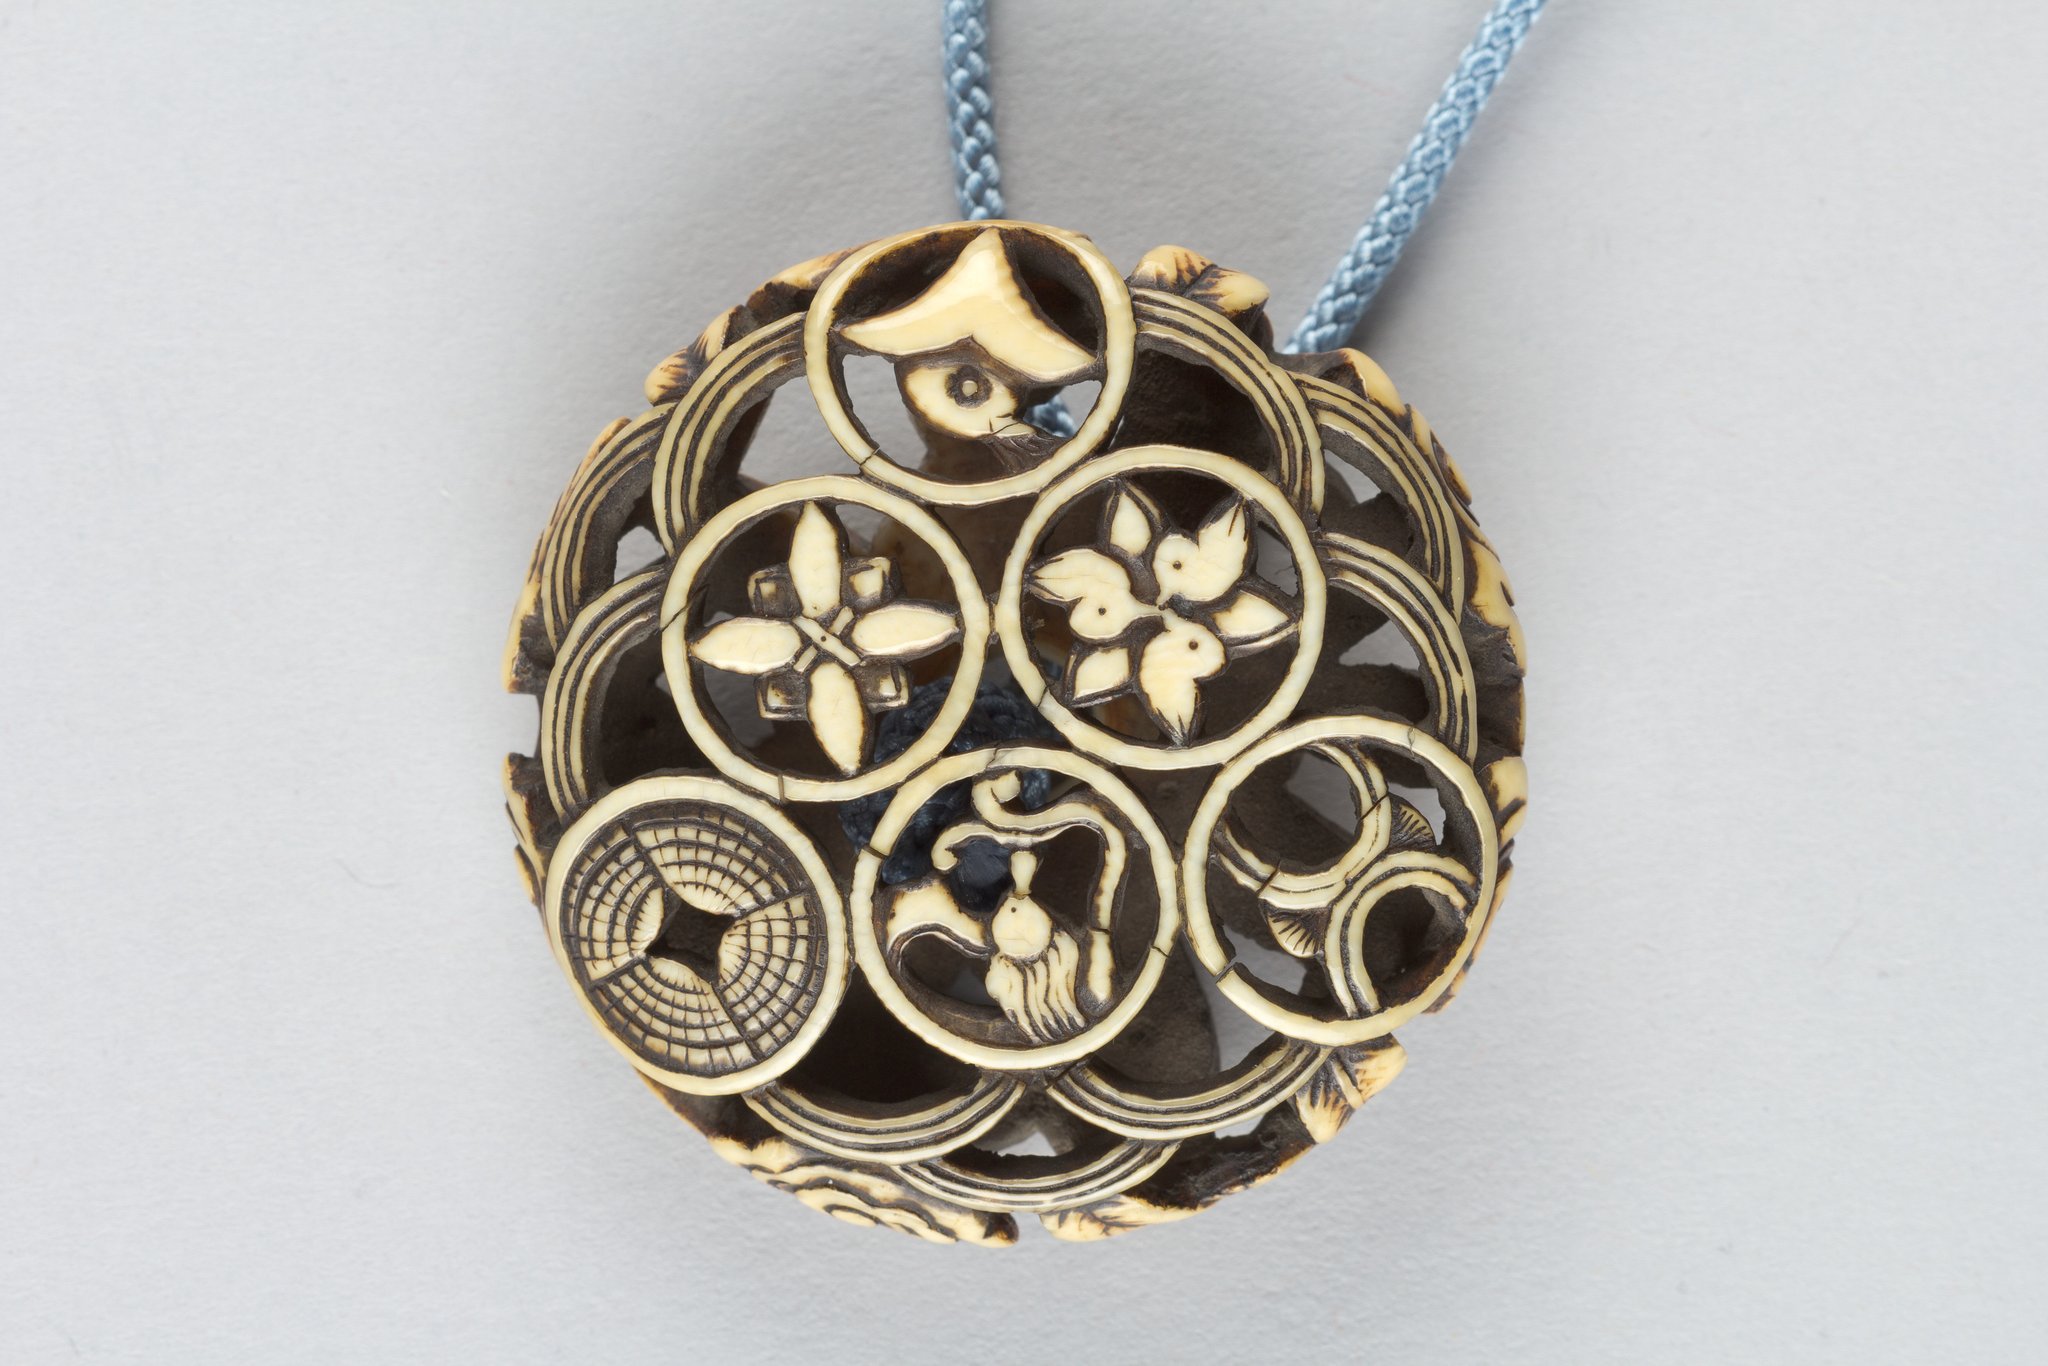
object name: netsuke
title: Netsuke with Carved Openwork Design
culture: japanese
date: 1801-1900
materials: ivory